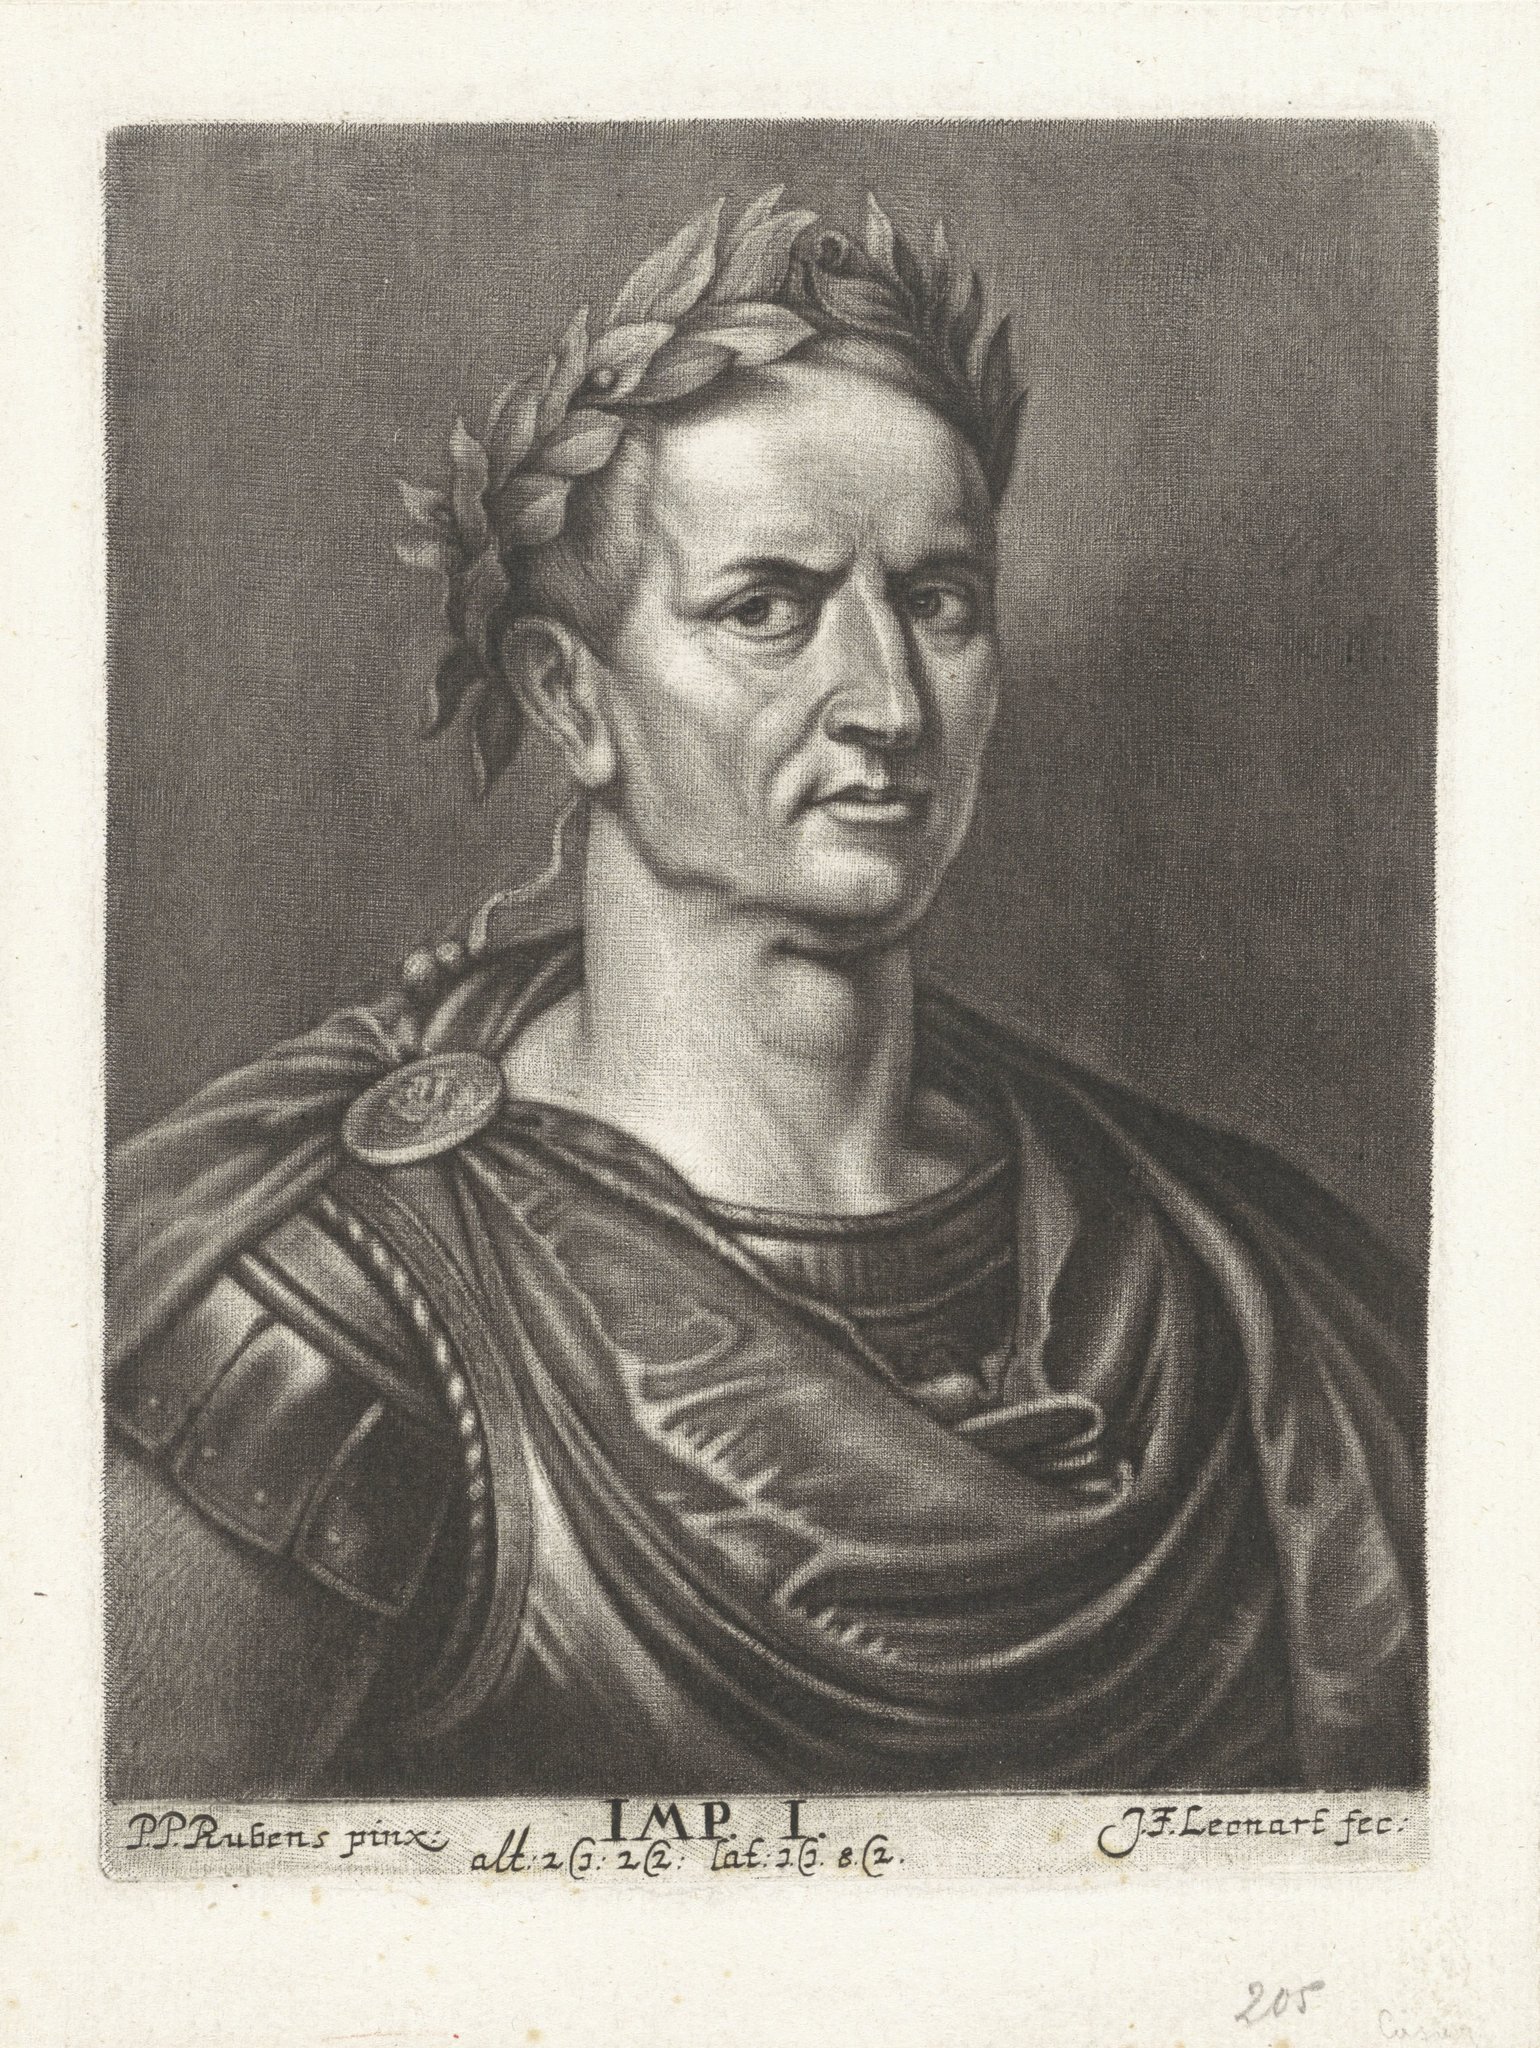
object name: print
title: Portret van keizer Julius Caesar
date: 1643-1680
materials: paper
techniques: engraving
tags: keizer, julius caesar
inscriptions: collector's mark: Lugt 2165